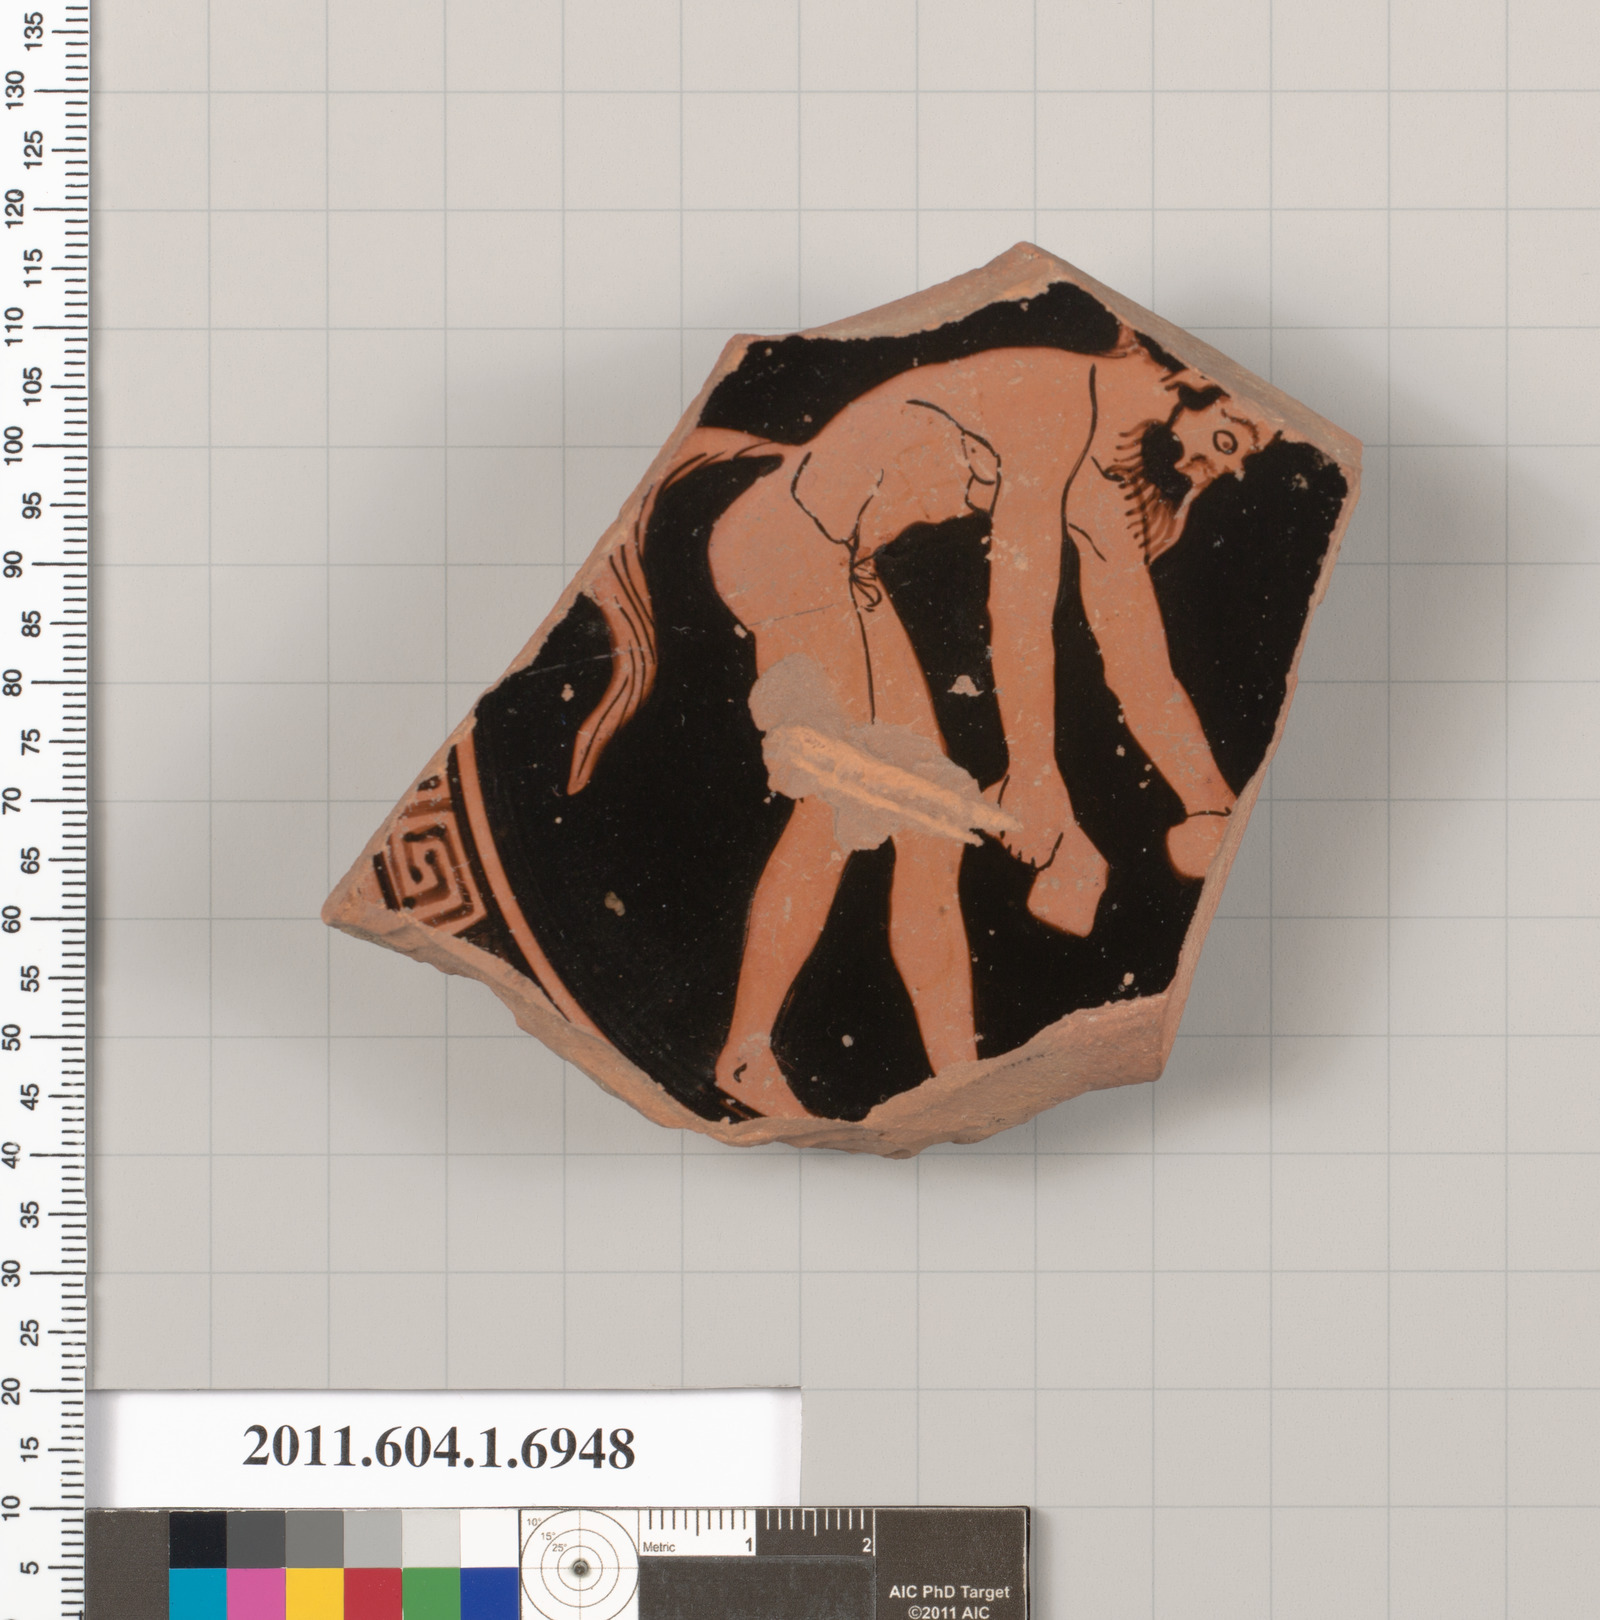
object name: kylix fragment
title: Terracotta fragment of a kylix (drinking cup)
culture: greek, attic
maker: painter of the paris gigantomachy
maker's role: artist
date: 480-470 BCE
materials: terracotta